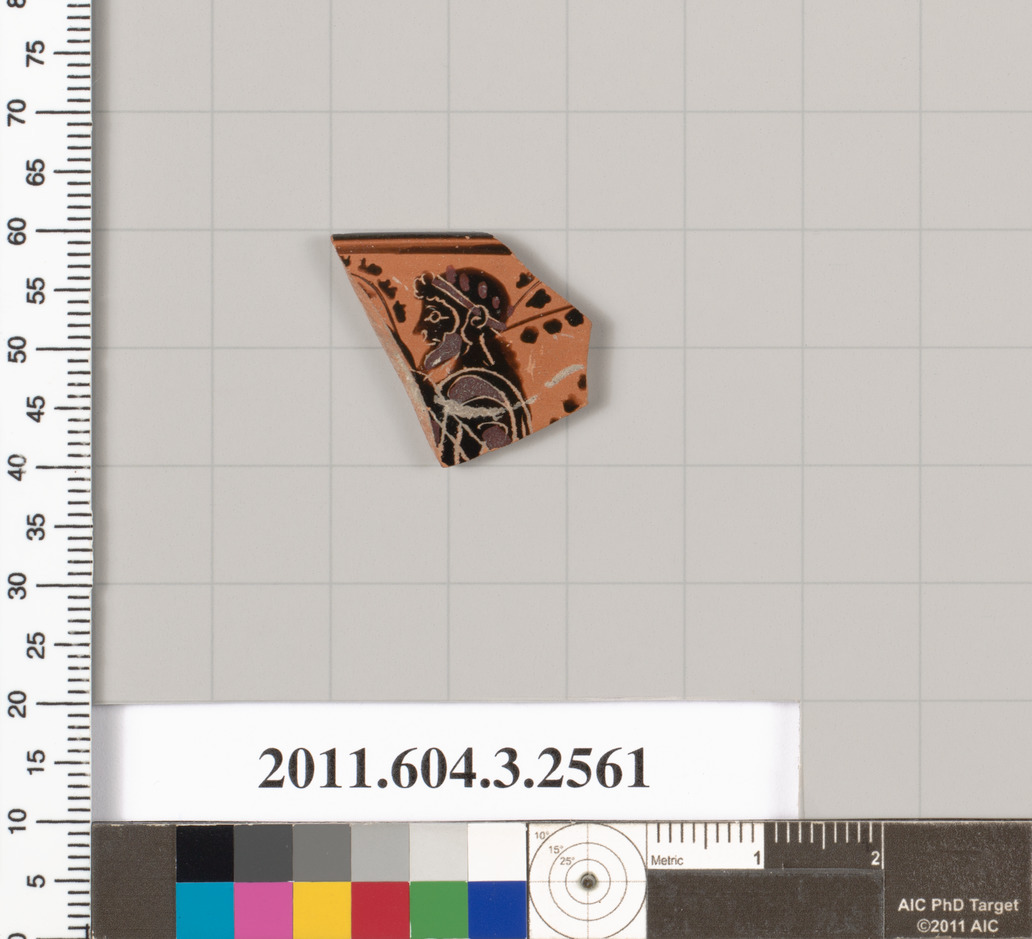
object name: kylix fragment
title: Terracotta rim fragment of a kylix (drinking cup)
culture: greek, attic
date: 534-468 BCE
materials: terracotta